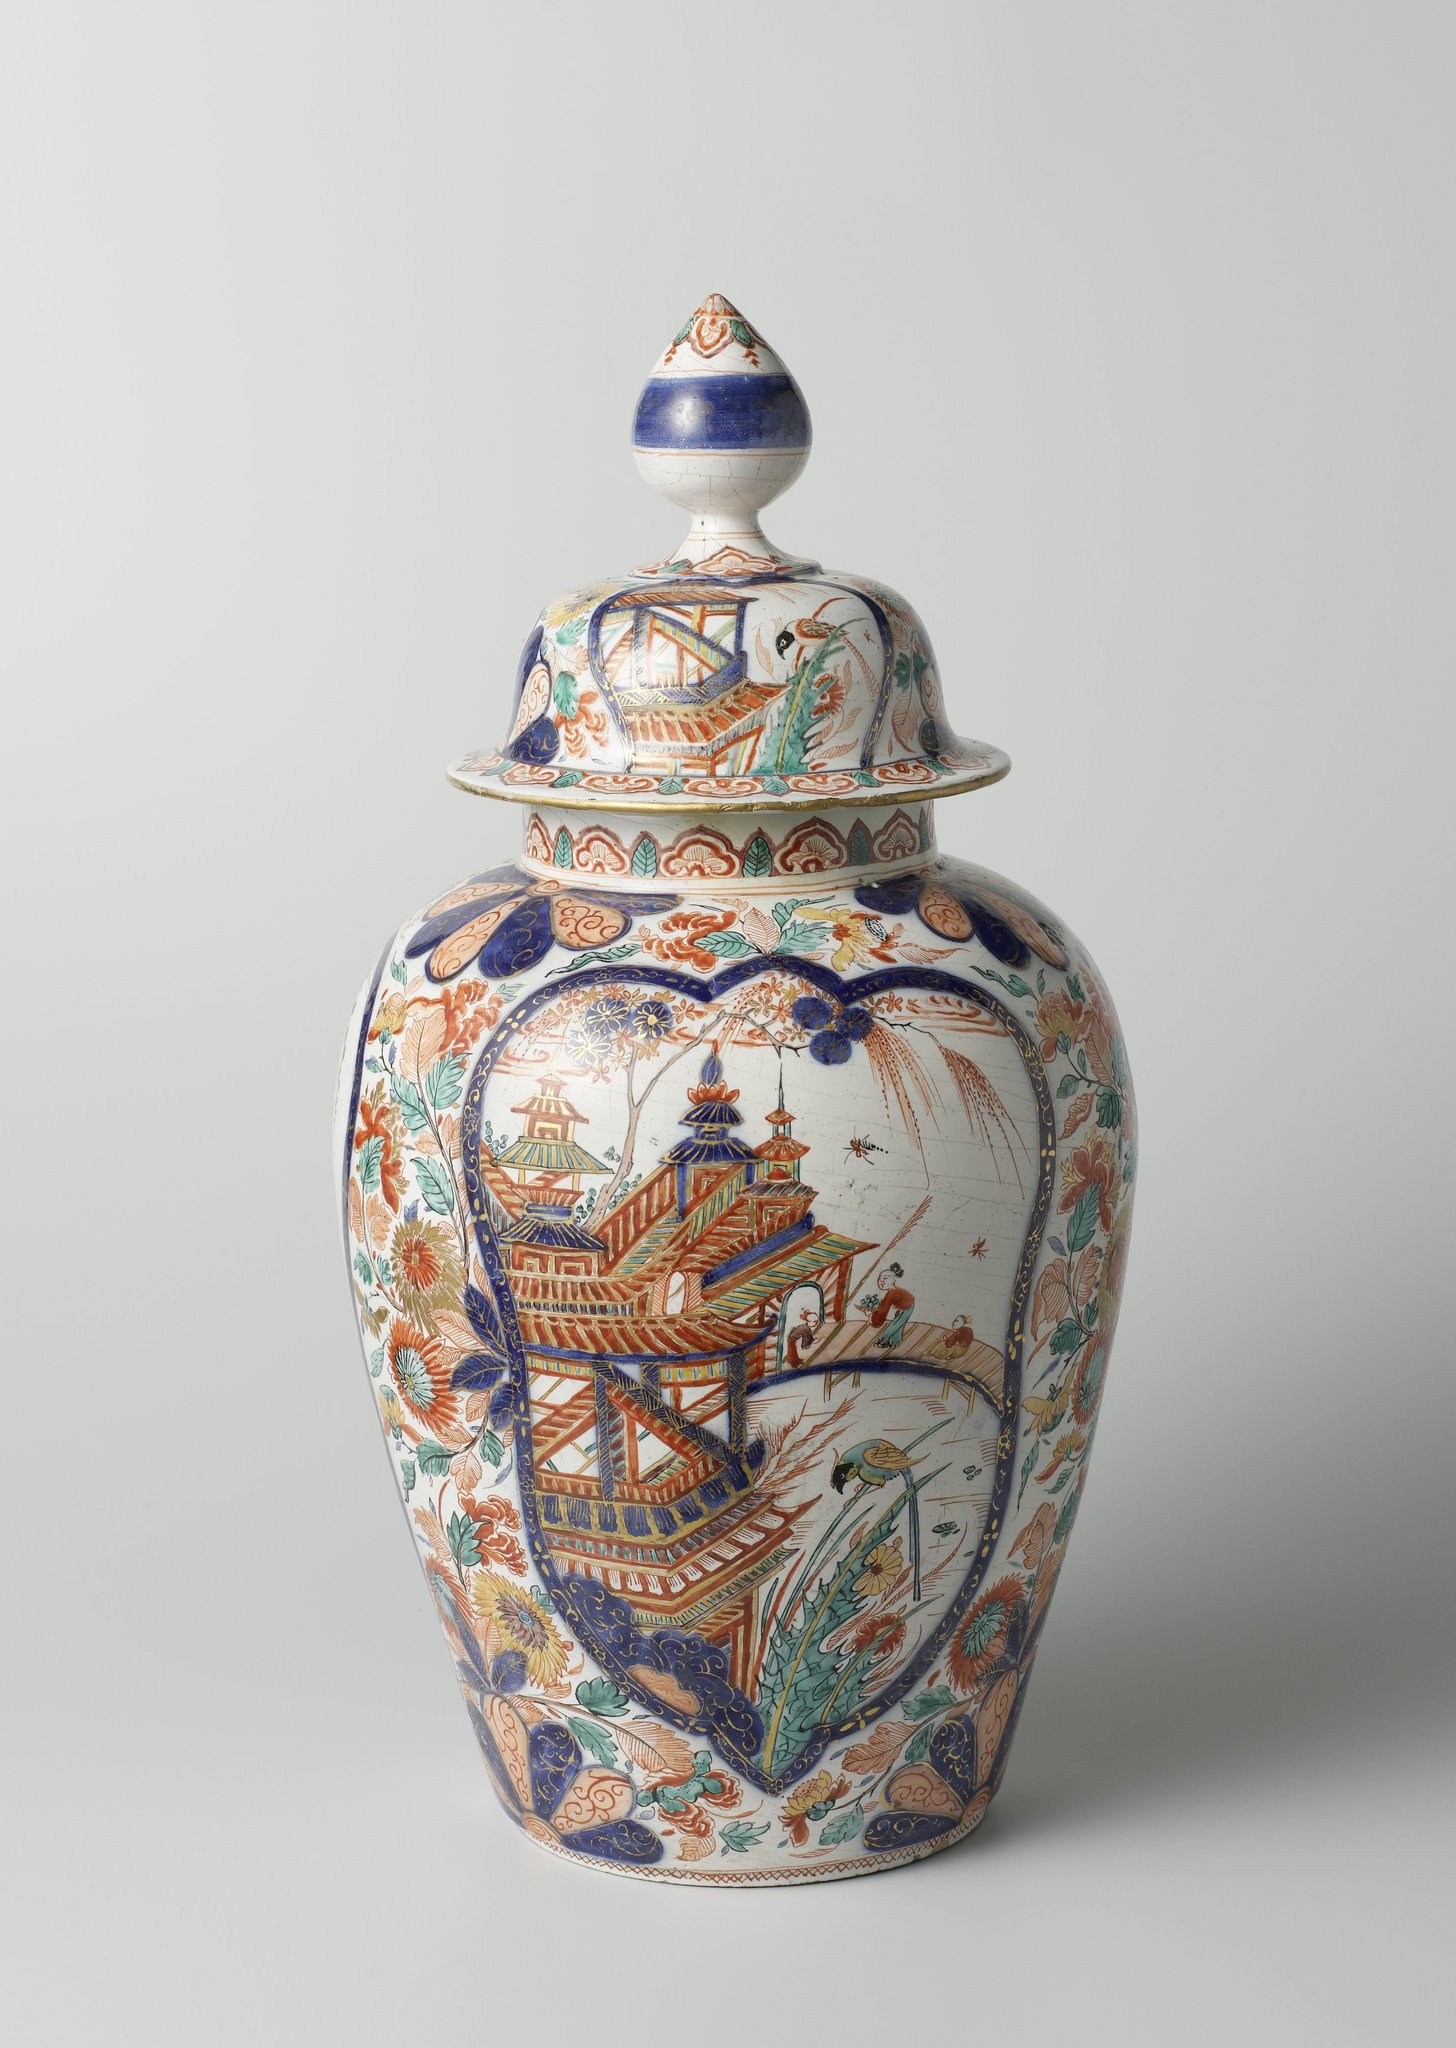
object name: pot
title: Lidded jar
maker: Anonymous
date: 1720-1740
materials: earthenware, glaze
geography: delft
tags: chinese (+ other cultural aspects)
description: Pot met deksel van faïence. Veelkleurig beschilderd met chinese huizen en bloemendecoratie.